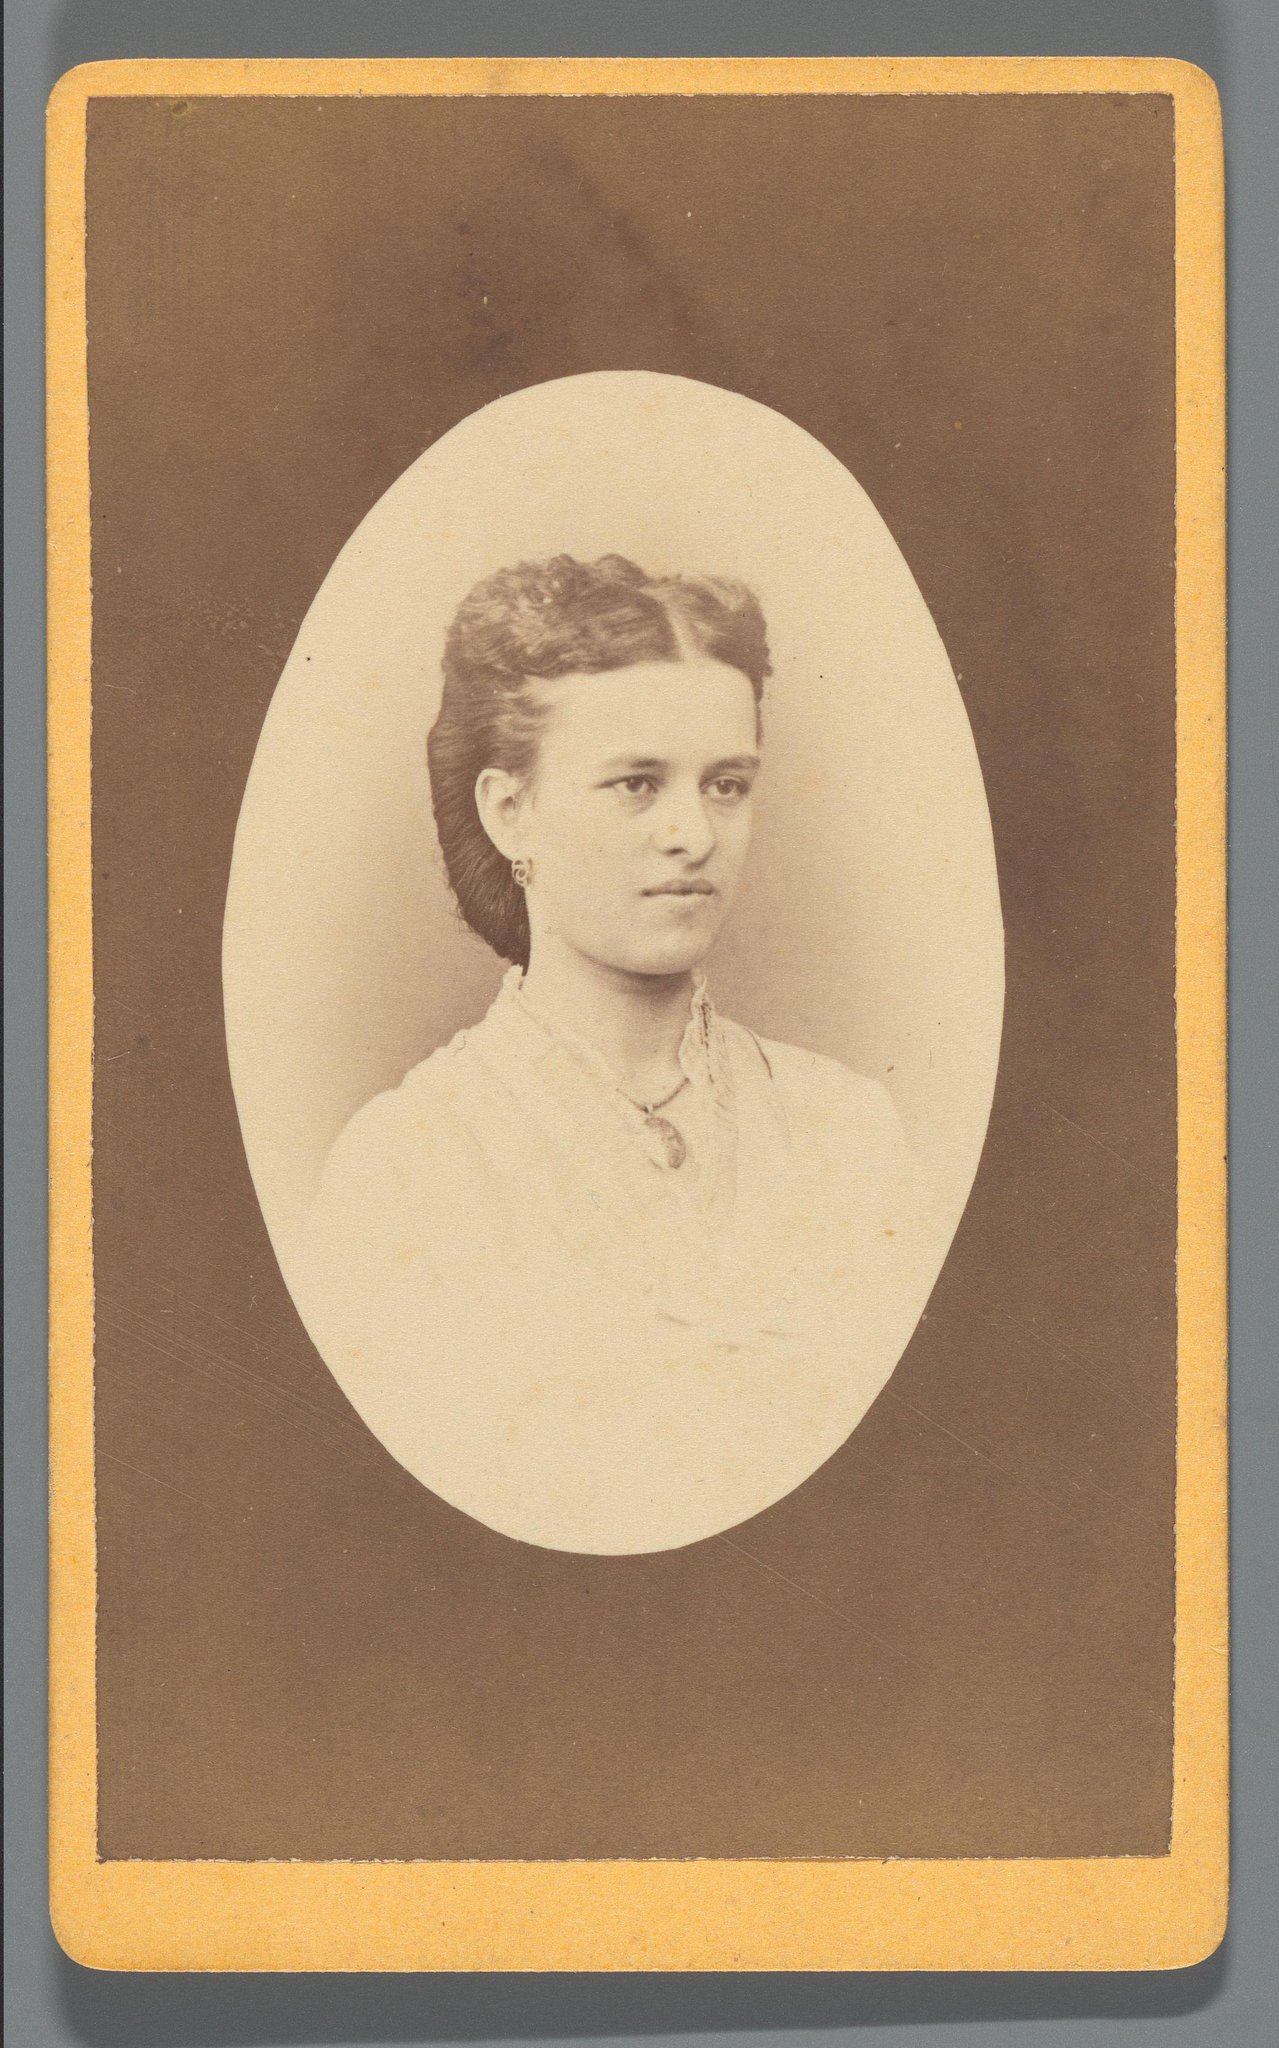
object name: photograph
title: Studioportret van Francina Schas in ovaal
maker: j.h. de bruijn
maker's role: fotograaf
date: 1865-1880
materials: cardboard, photographic support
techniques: albumen print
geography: semarang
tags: francina schas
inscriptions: inscription: ‘F.W.S. vandenBerg / Schas’, name: ‘J.H. DE BRUIJN / PHOTOGRAAF / SAMARANG’